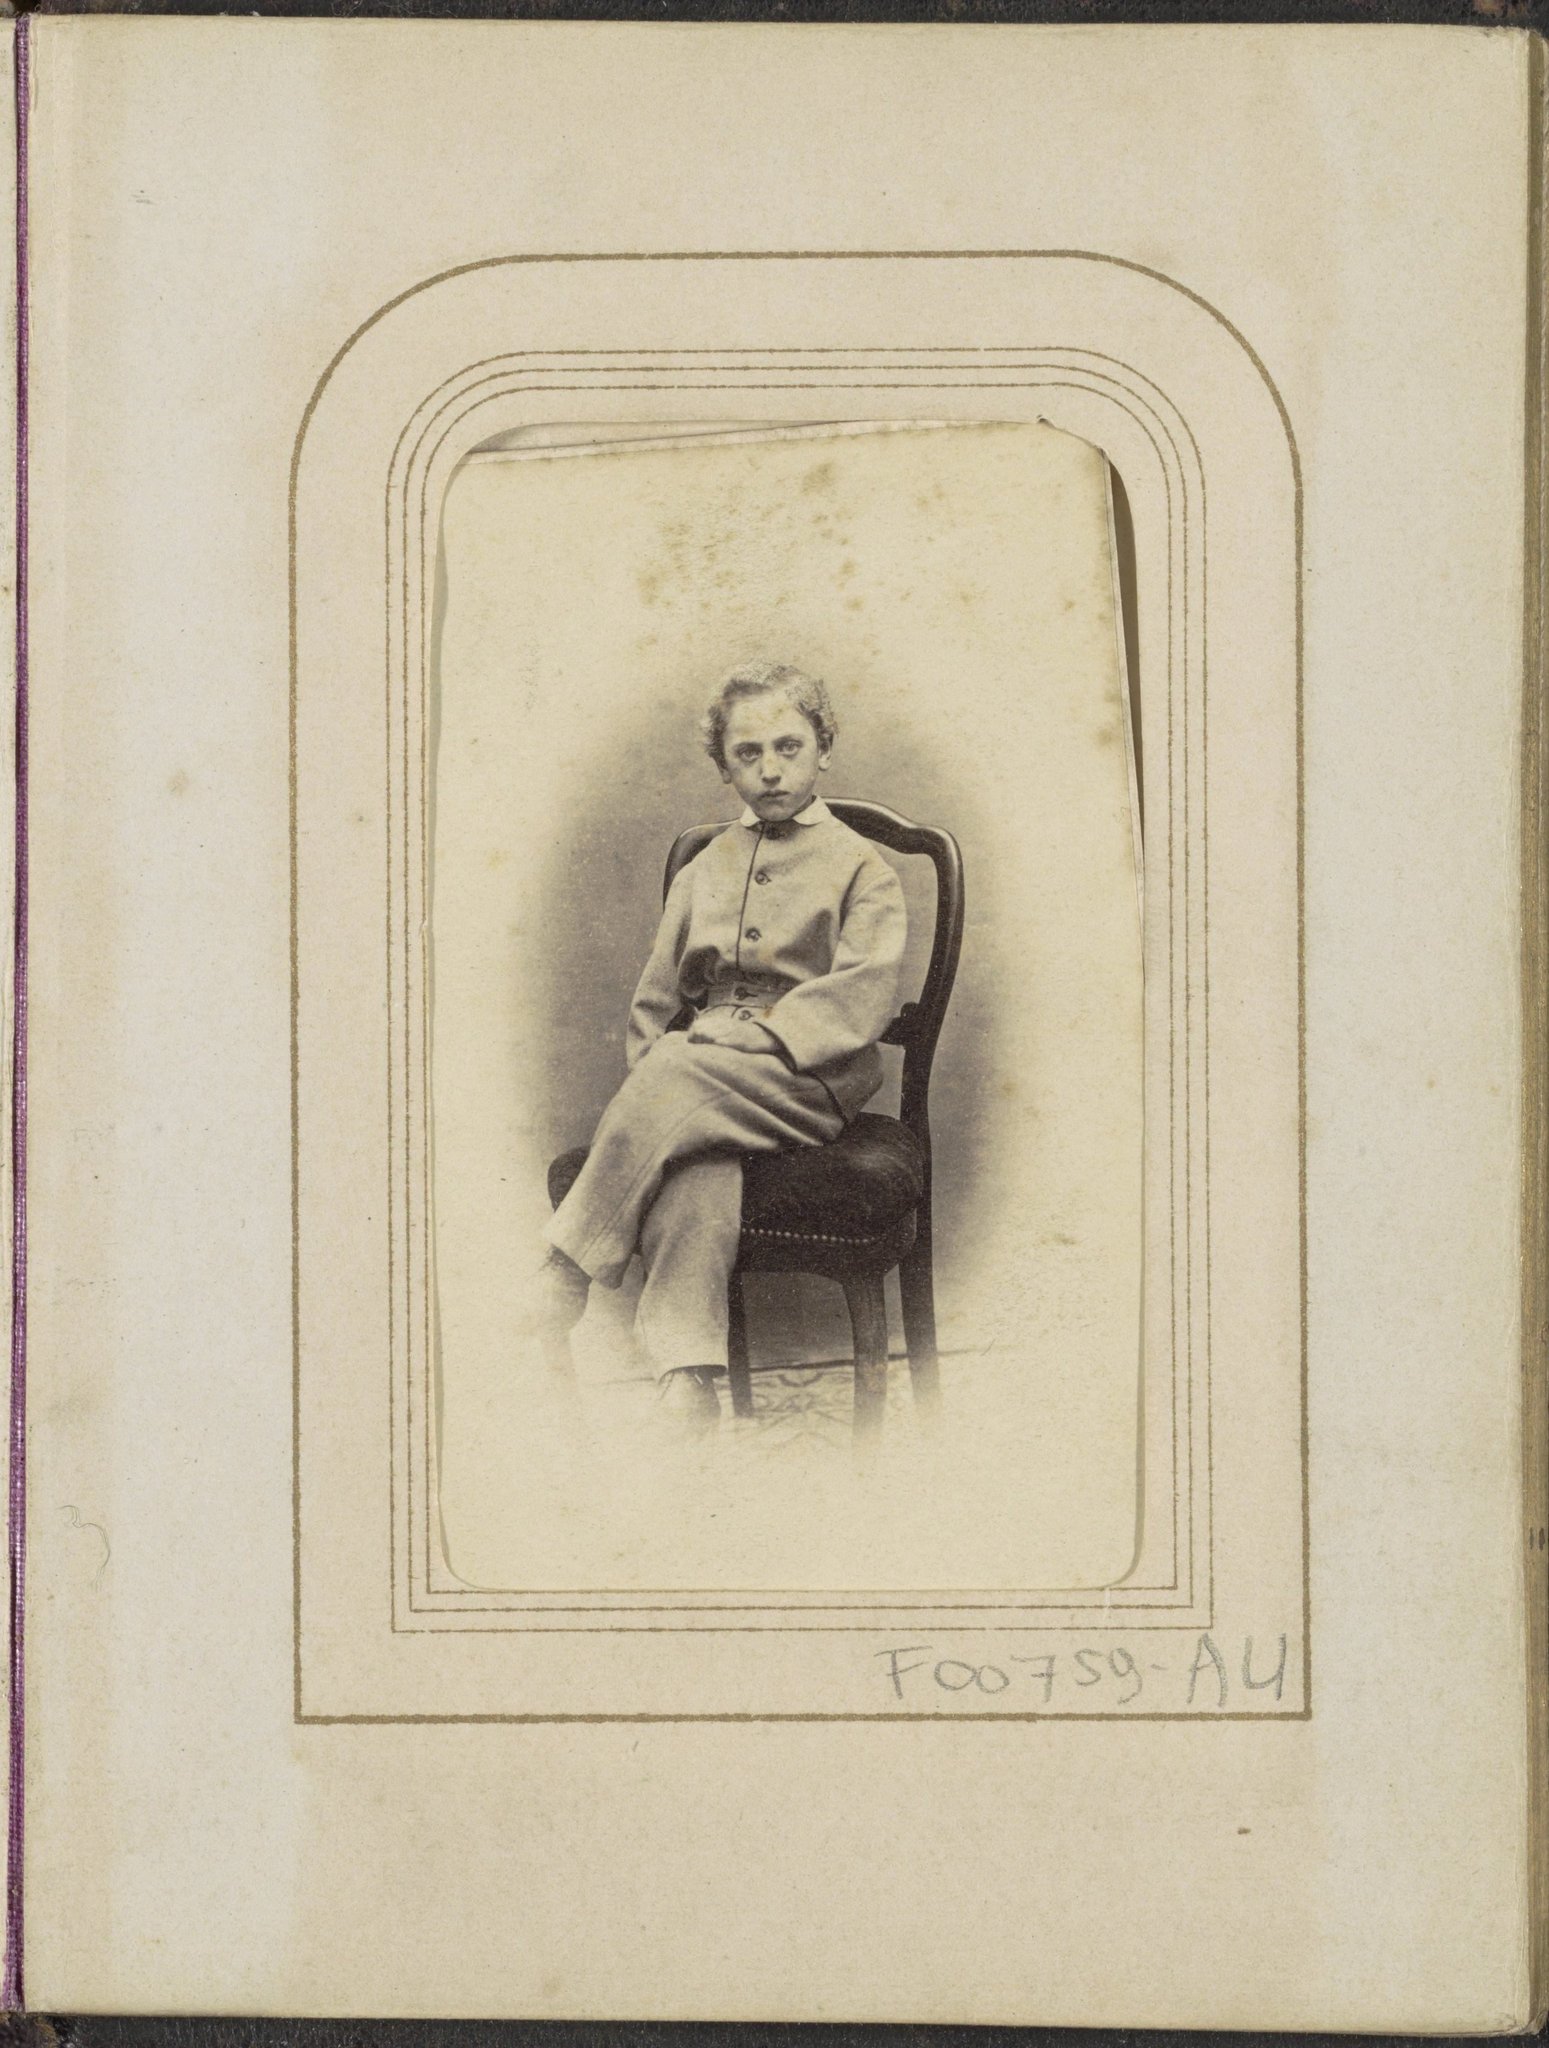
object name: photograph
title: Portret van een jongen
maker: Anonymous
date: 1860-1880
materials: cardboard, paper, photographic support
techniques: albumen print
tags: historical persons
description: Onderdeel van Fotoalbum van een Nederlandse familie met 50 cartes-de-visite.